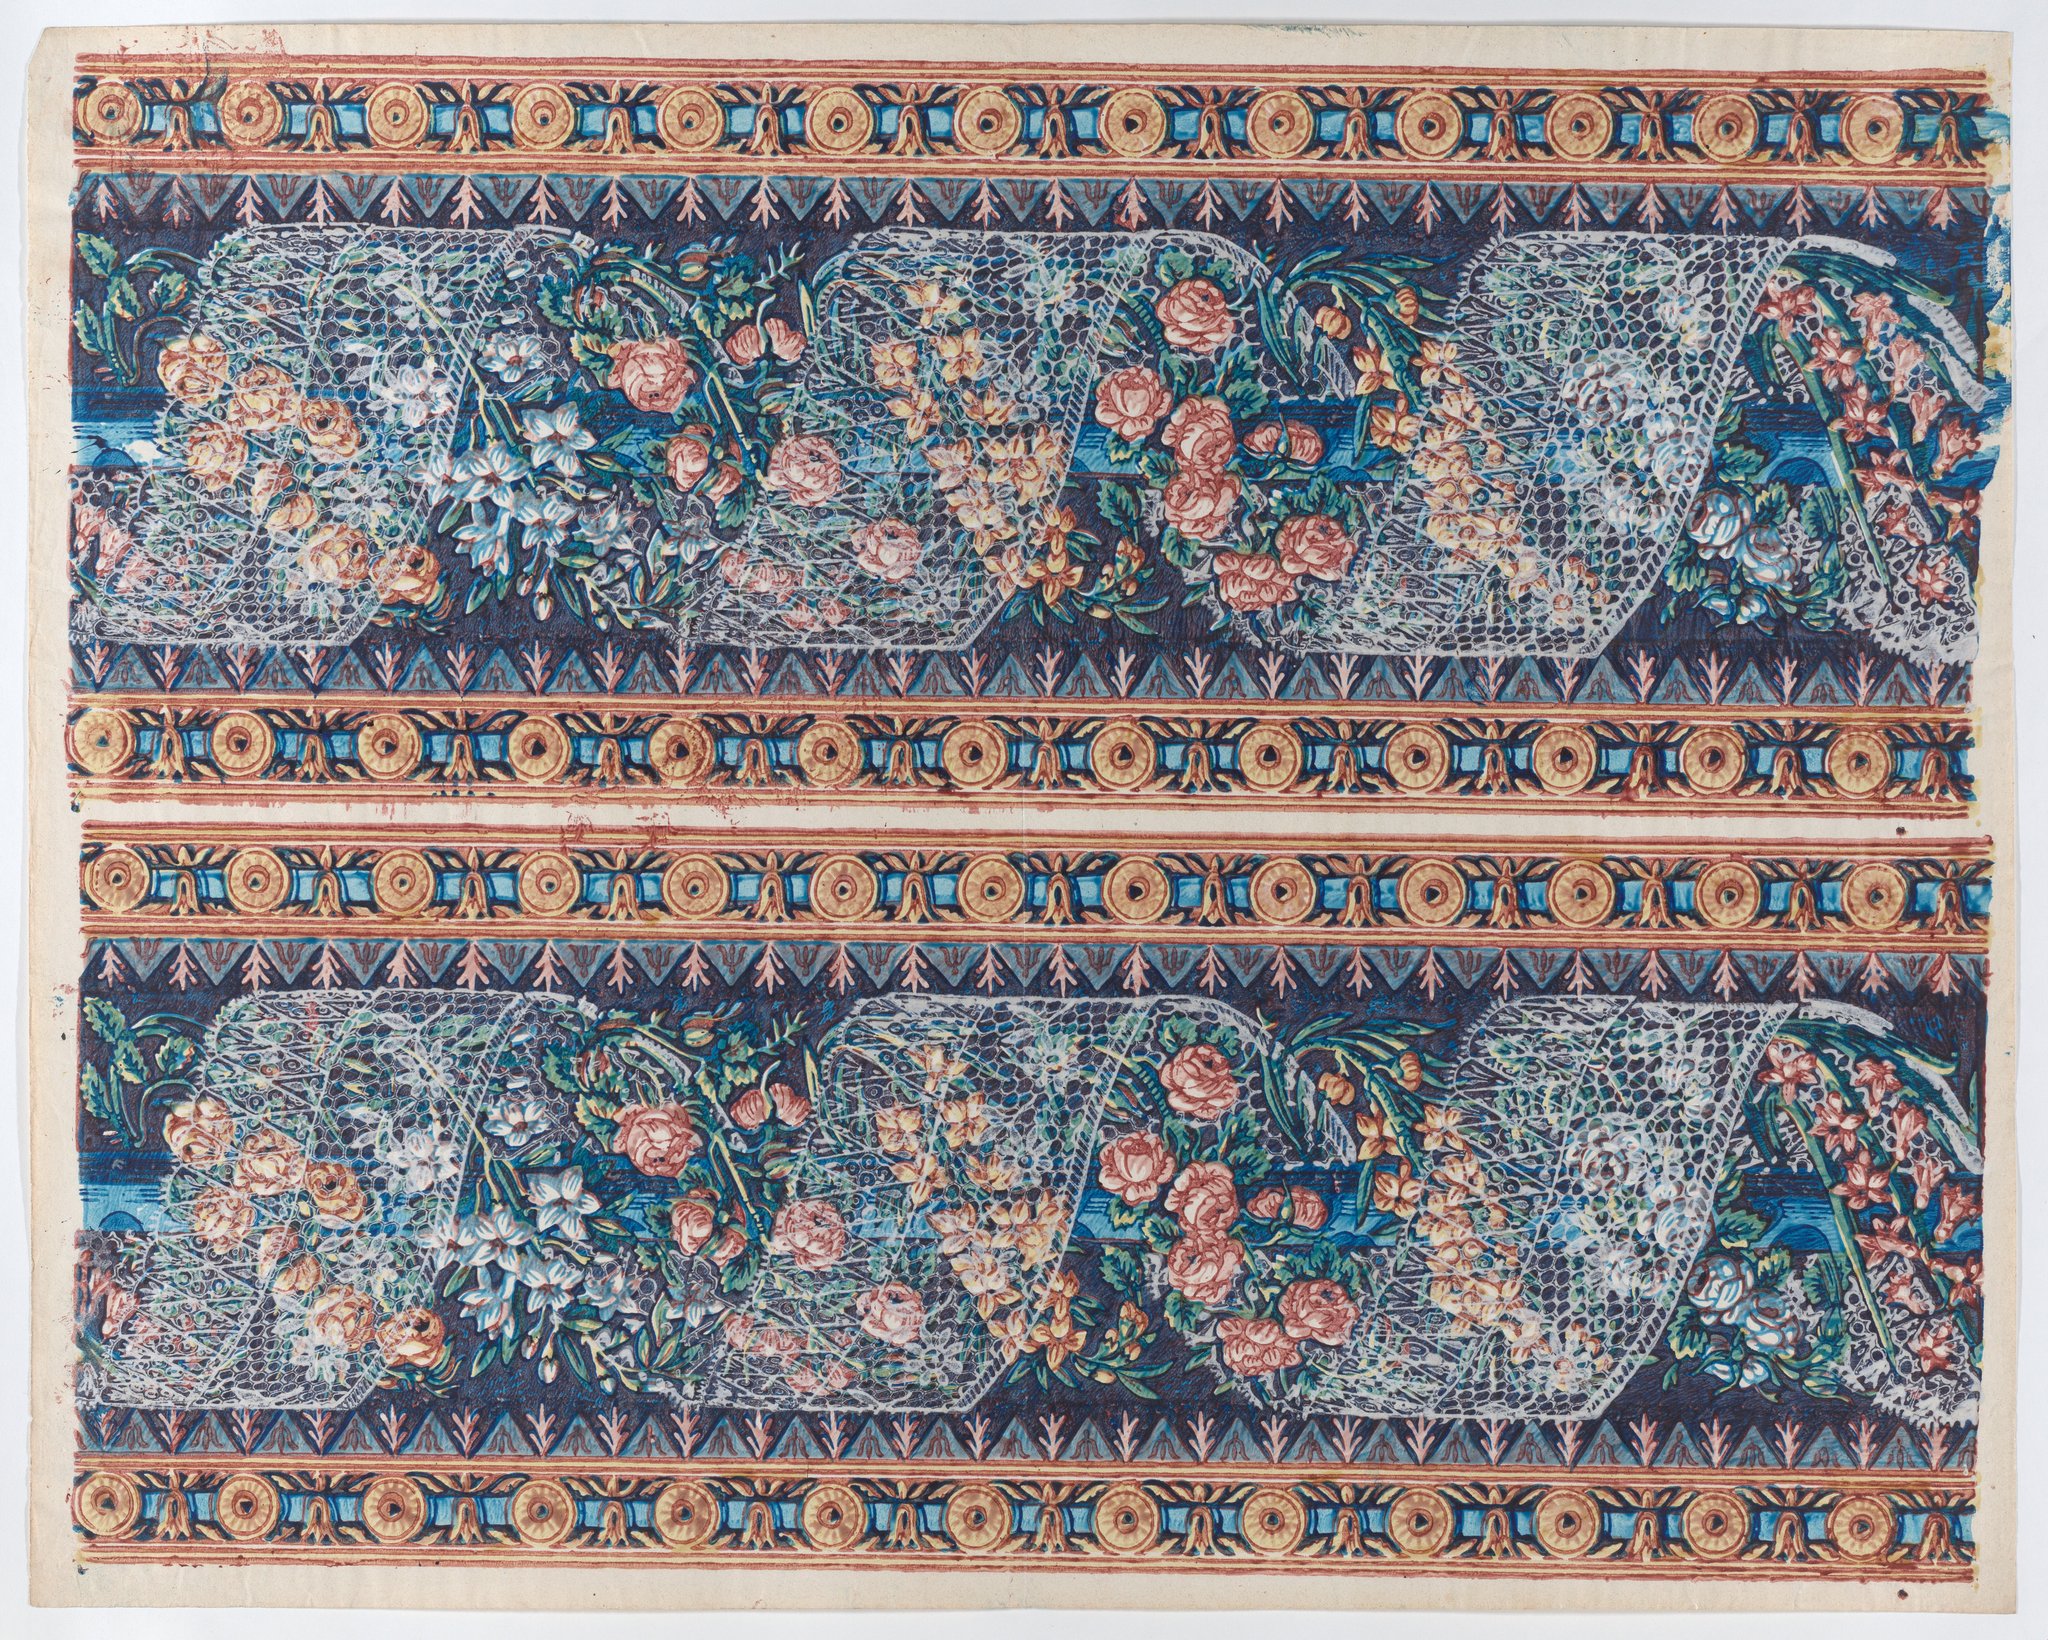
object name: print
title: Sheet with two borders with lace atop a floral garland against a navy background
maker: Anonymous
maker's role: artist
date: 1767-1866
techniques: relief print